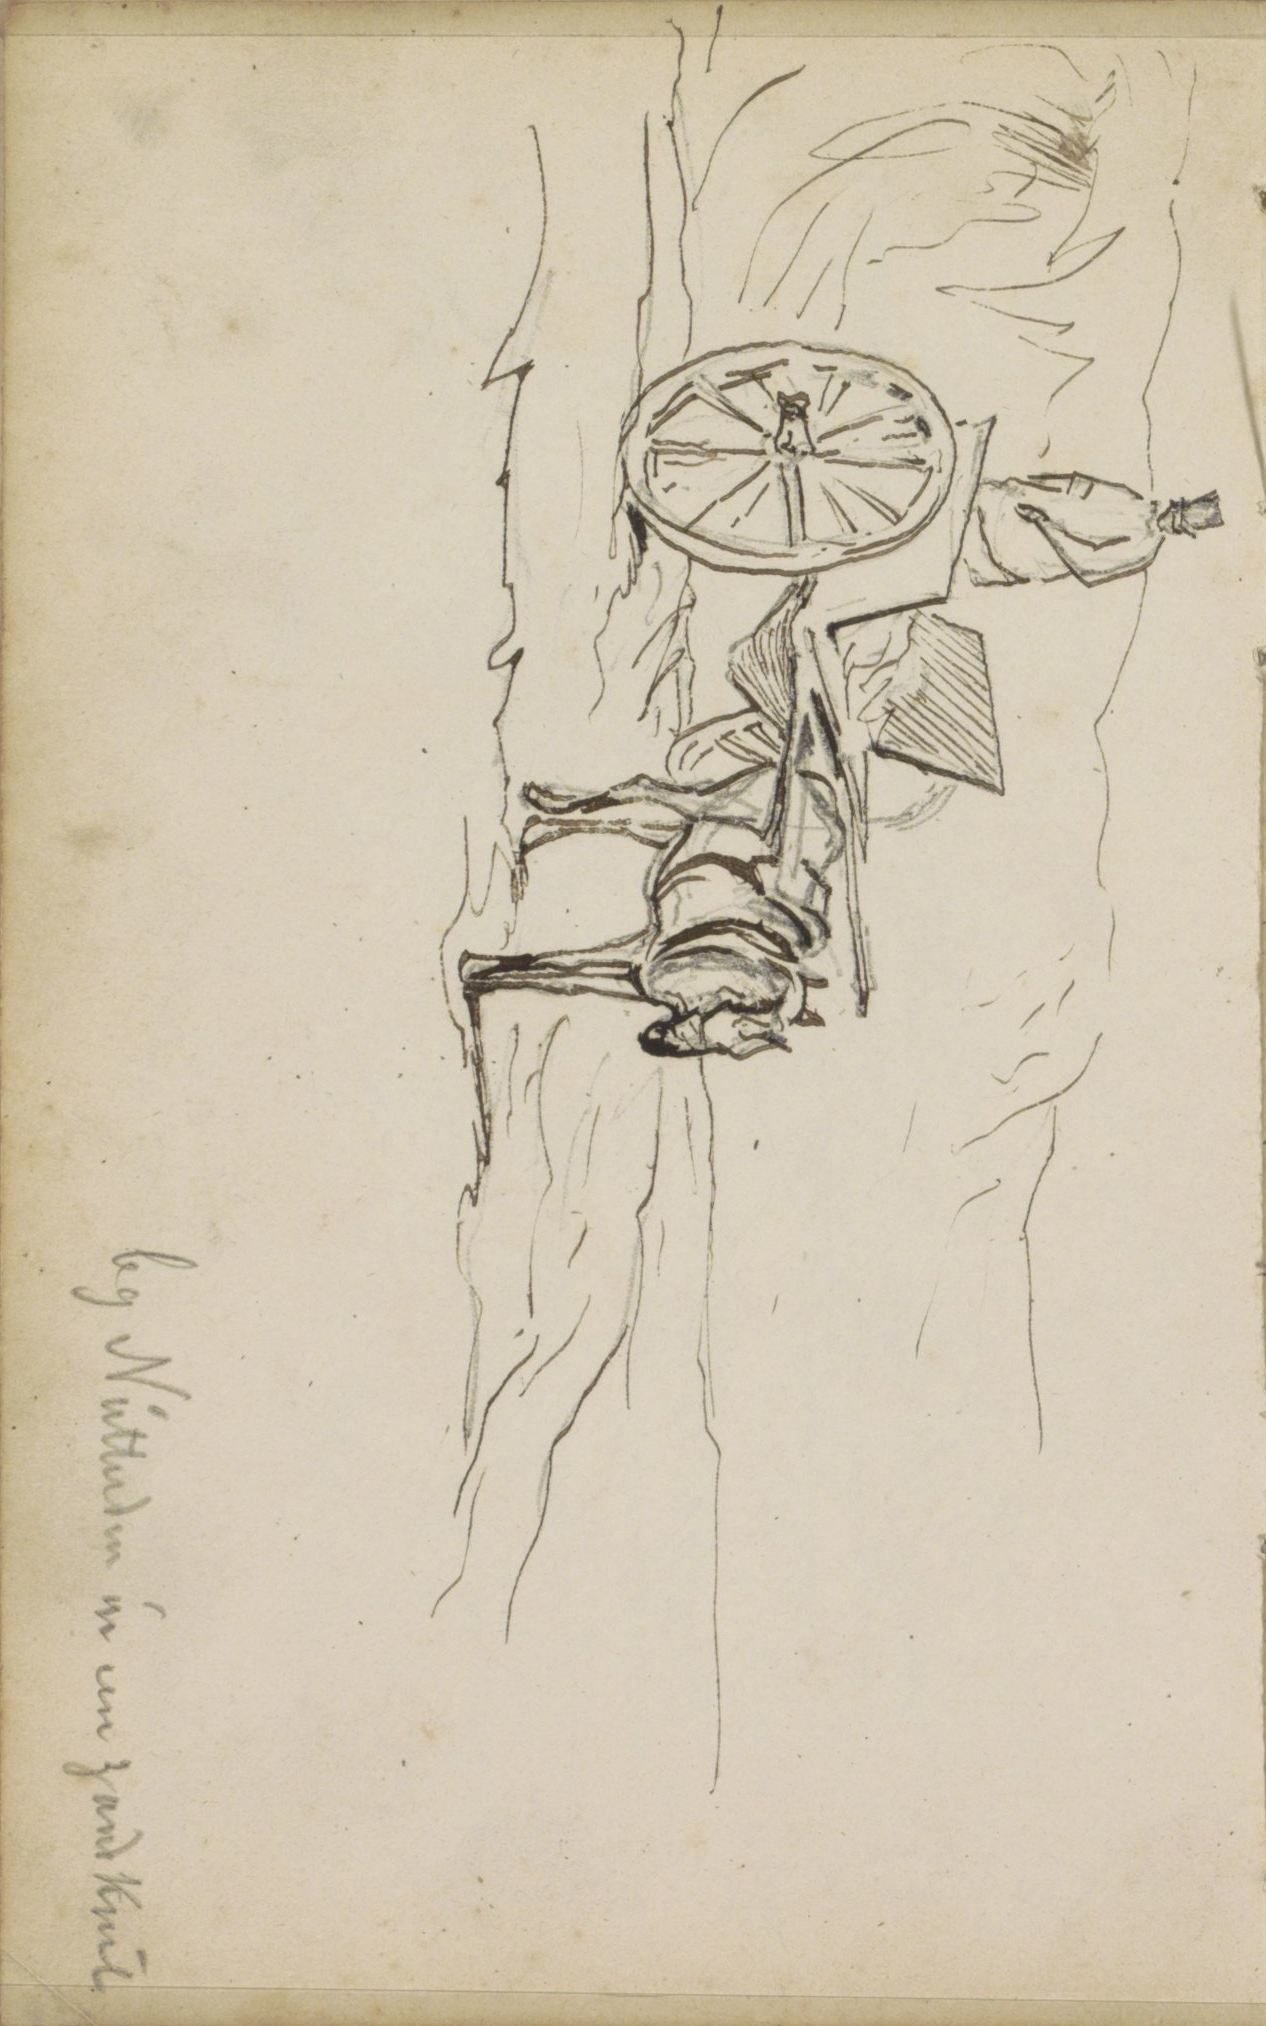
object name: sketchbook leaf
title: Zandkuil met een figuur op een paardenkar in Nütterden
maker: johannes tavenraat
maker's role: draughtsman, painter, print maker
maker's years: 1809-1881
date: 1839-1872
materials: ink, paper, pencil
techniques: pen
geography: kranenburg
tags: sand (soil type), standing figure, horse, (farm) wagon, freight wagon, cart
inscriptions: annotation: ‘N[...]ttu[..] in een zant kuil’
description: Blad 68 verso uit een schetsboek met 73 bladen.